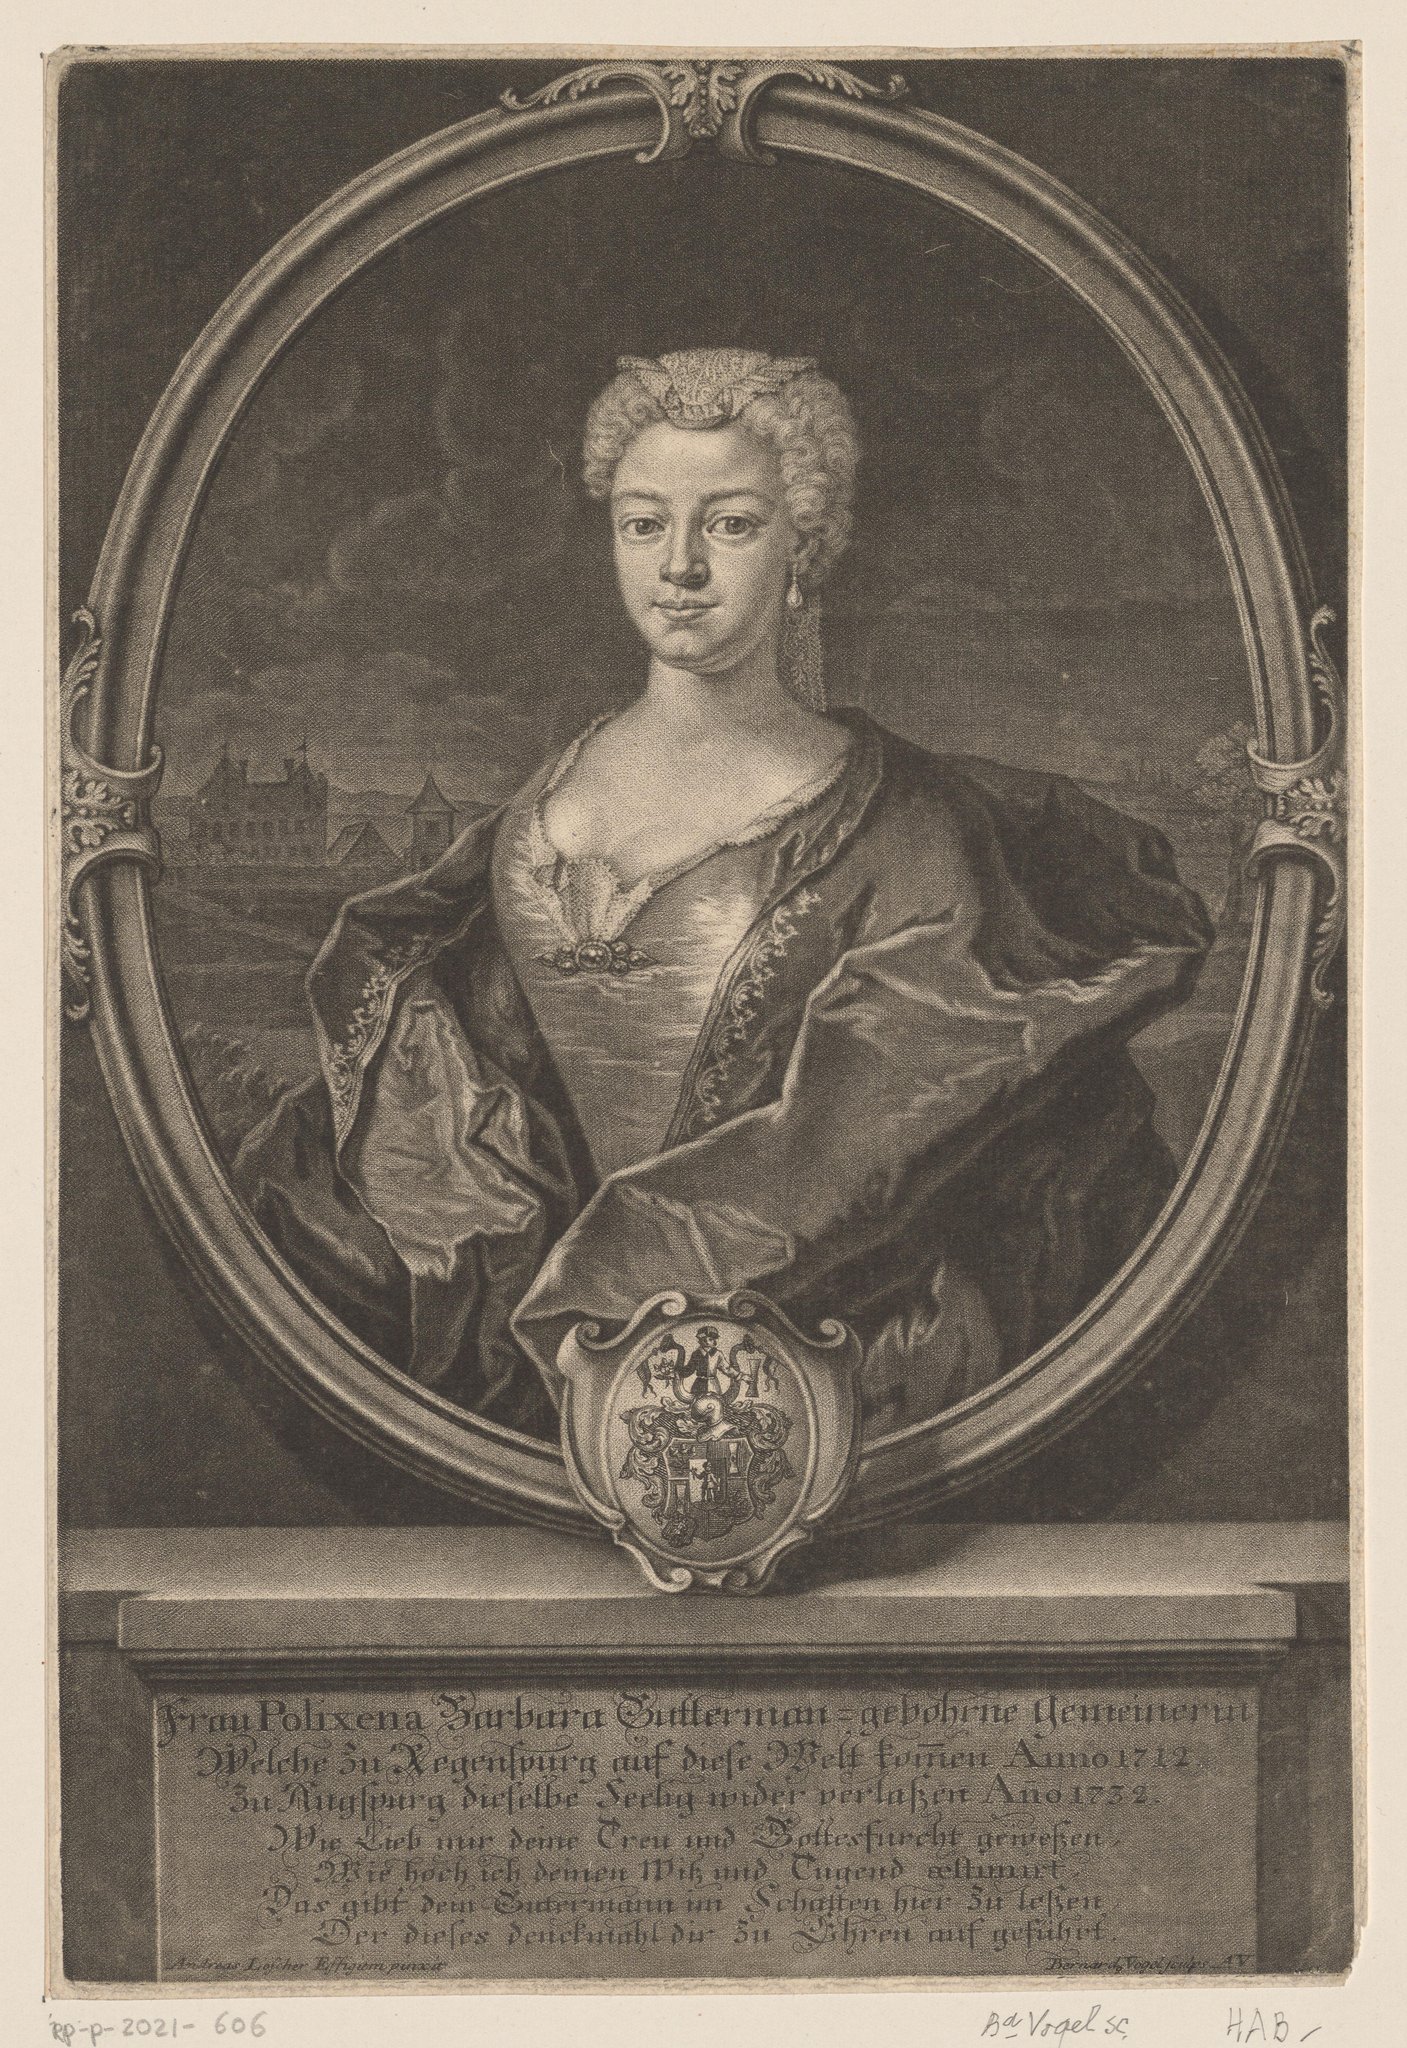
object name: print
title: Portret van Polyxena Barbara Gutermann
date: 1732-1737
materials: paper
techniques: mezzotint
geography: augsburg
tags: historical persons, armorial bearing, heraldry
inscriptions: collector's mark: Lugt 2228